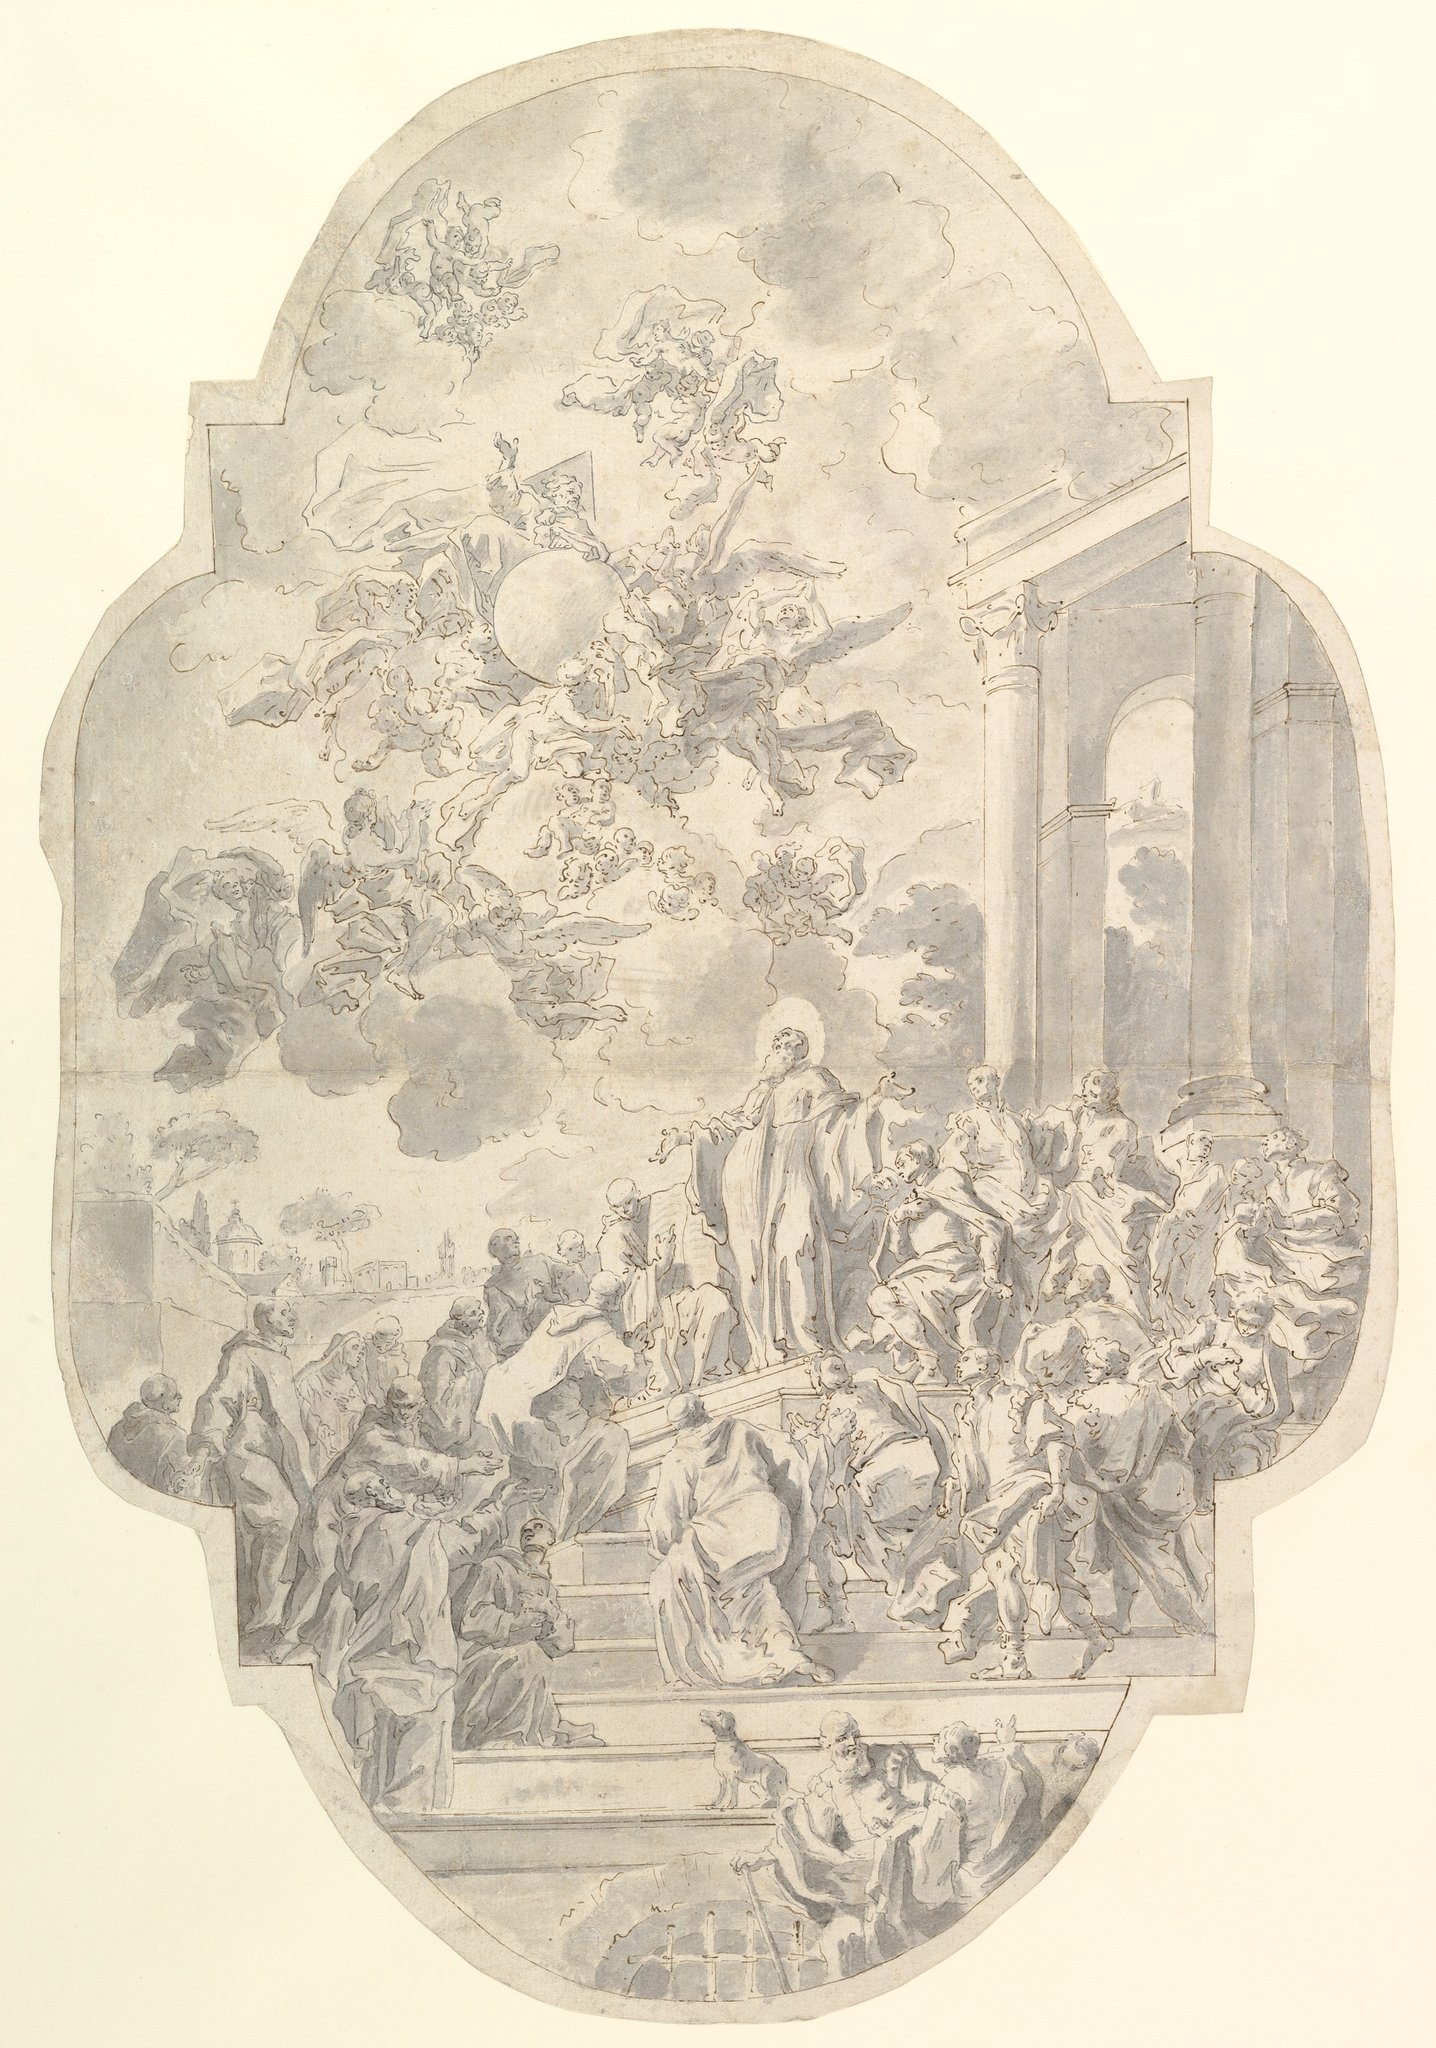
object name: drawing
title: The Vision of Saint Benedict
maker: francesco de mura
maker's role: artist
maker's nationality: italian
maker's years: 1696-1782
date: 1740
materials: graphite, ink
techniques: brush, pen, wash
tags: dogs,angels,saints